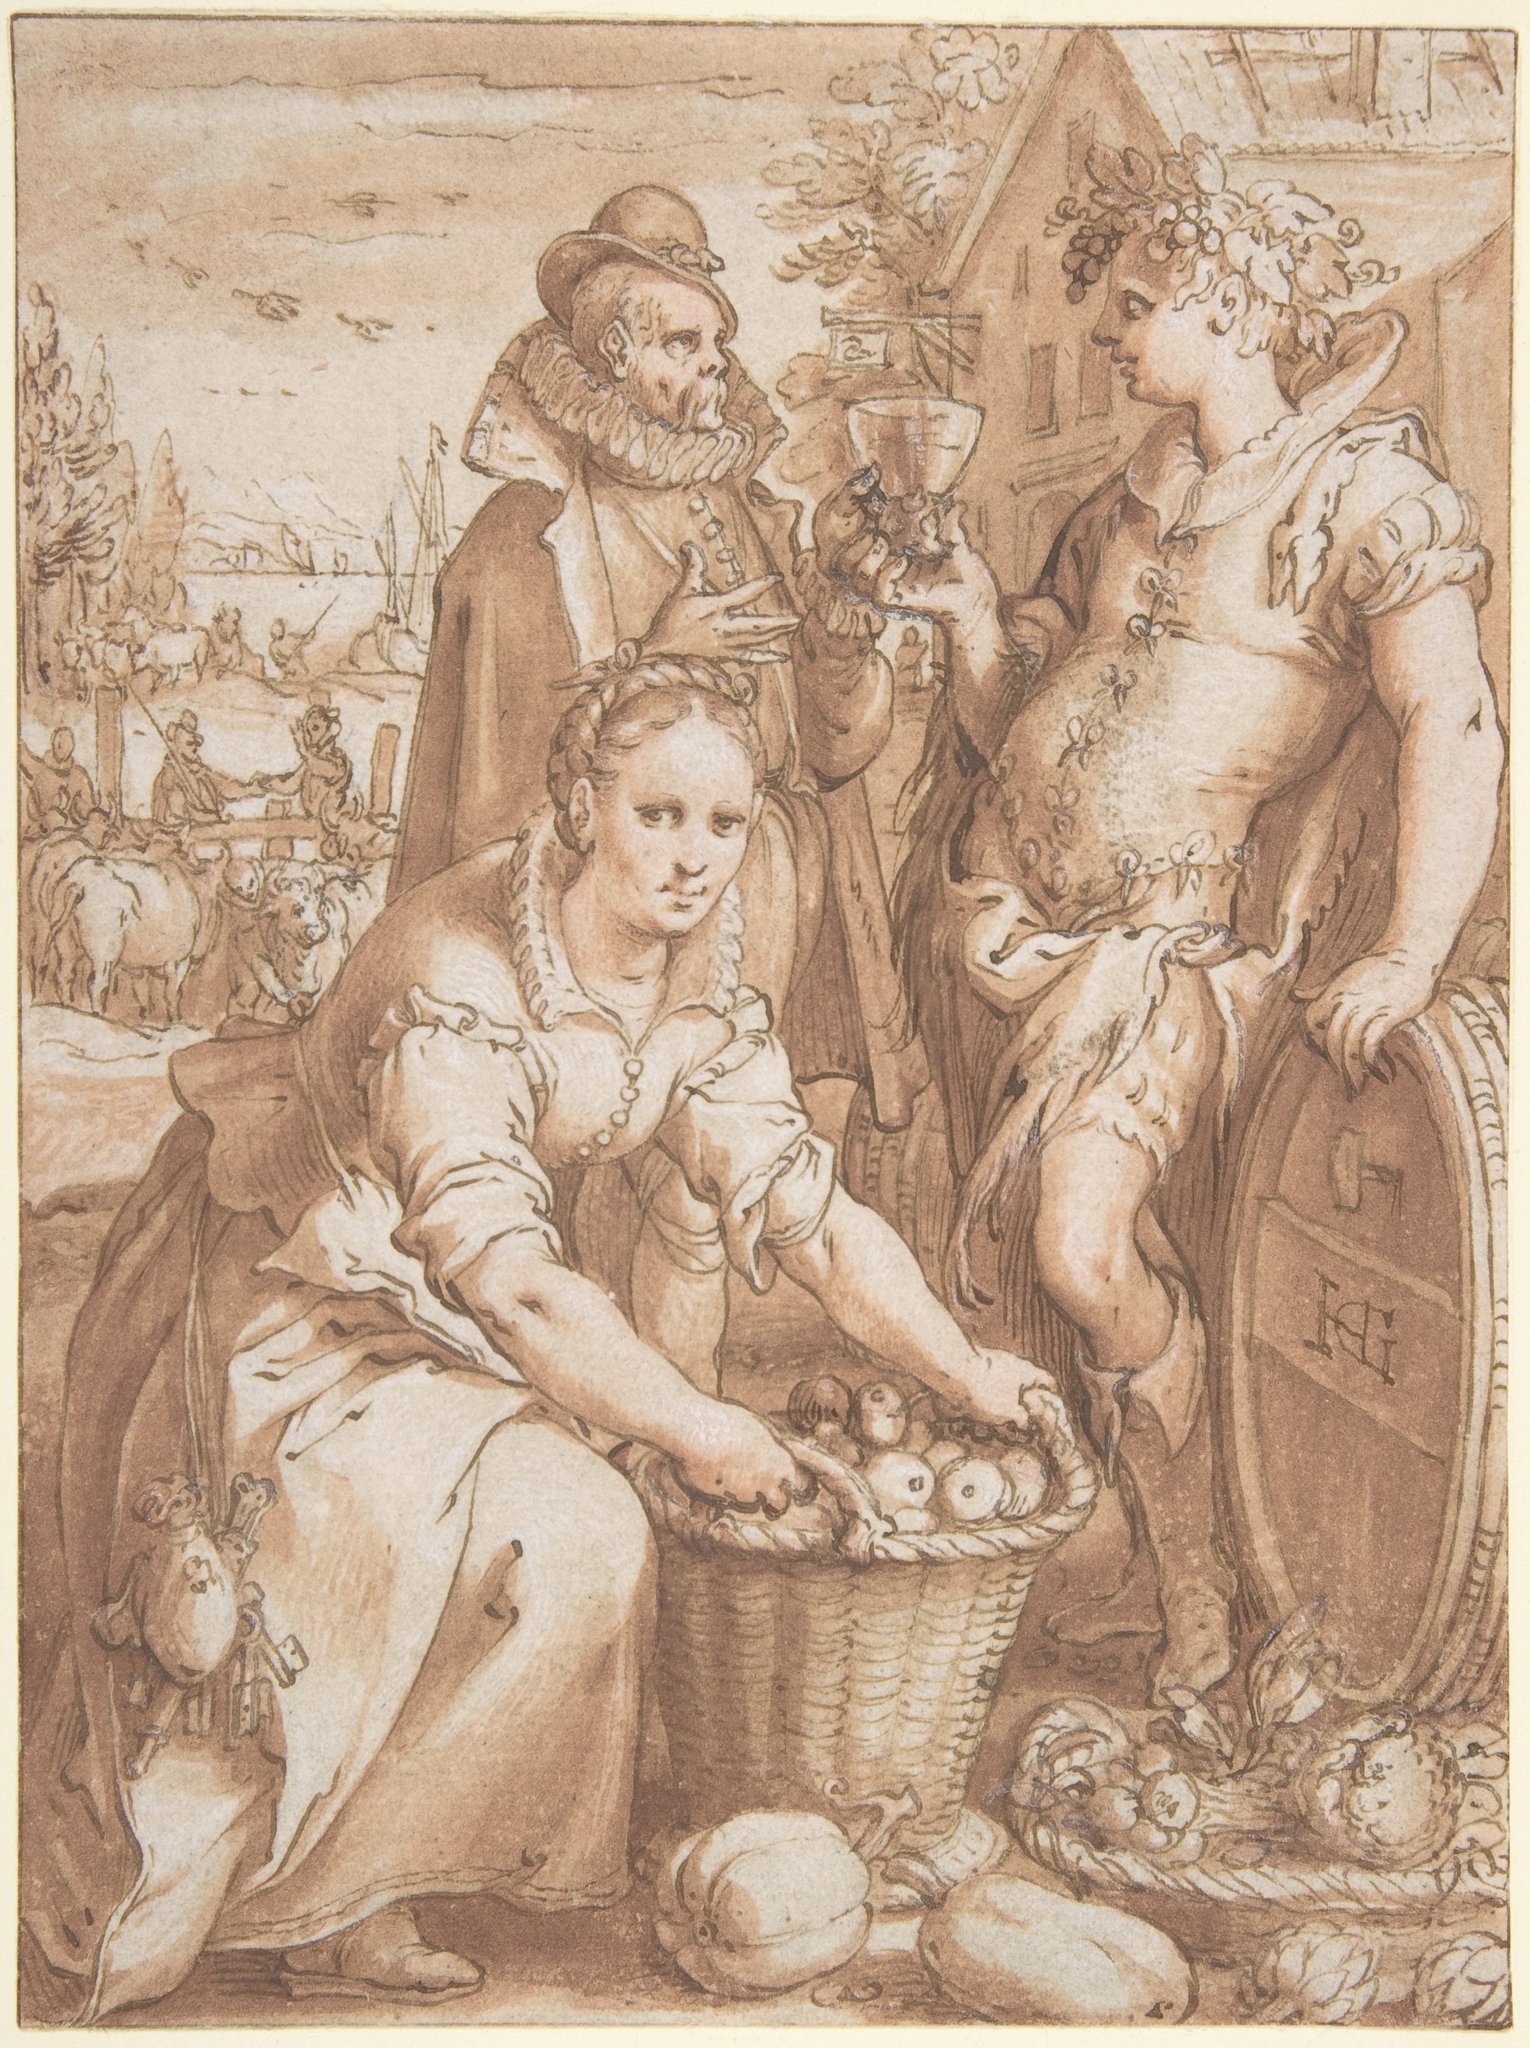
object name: drawing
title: Autumn; Study for an Engraving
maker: hendrick goltzius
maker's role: artist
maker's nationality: netherlandish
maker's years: 1558-1617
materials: chalk, gouache, ink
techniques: brush, heightening, pen, wash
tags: fruit,men,women,autumn,drinking